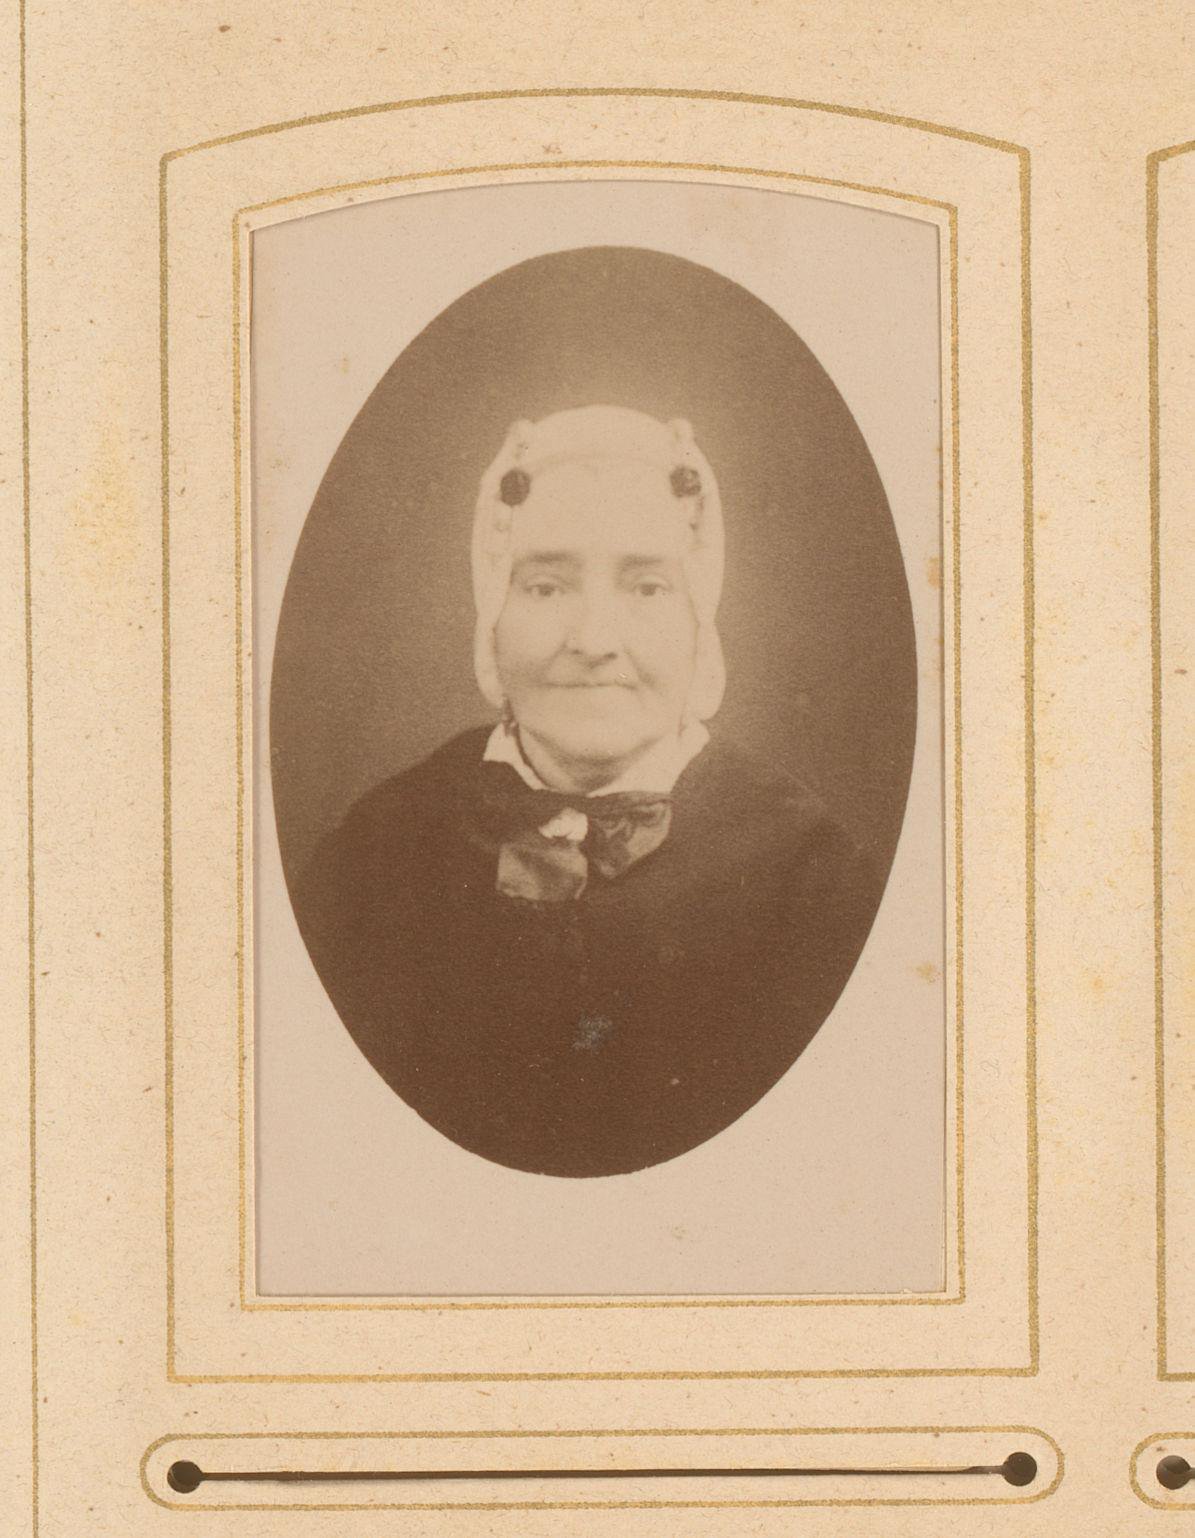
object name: carte de visite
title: Portret van een vrouw met witte klederdrachtmuts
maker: gerrit dirk siewers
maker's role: fotograaf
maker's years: 1846-1899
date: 1871-1891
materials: cardboard, photographic support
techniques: albumen print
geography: hoorn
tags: historical persons - bb - woman, head-gear: cap, folk costume, regional costume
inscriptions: inscription: ‘Photographie/ Instantanée/ van/ G. D. Siewers/ Hoorn/ Pieterseliesteeg/ Zuidzijde Groote Kerk./ Het cliché blijft ter nabestelling bewaard./ Inrichting voor onveranderlijke vergrootingen/ in alle formaten tot levensgrootte.’